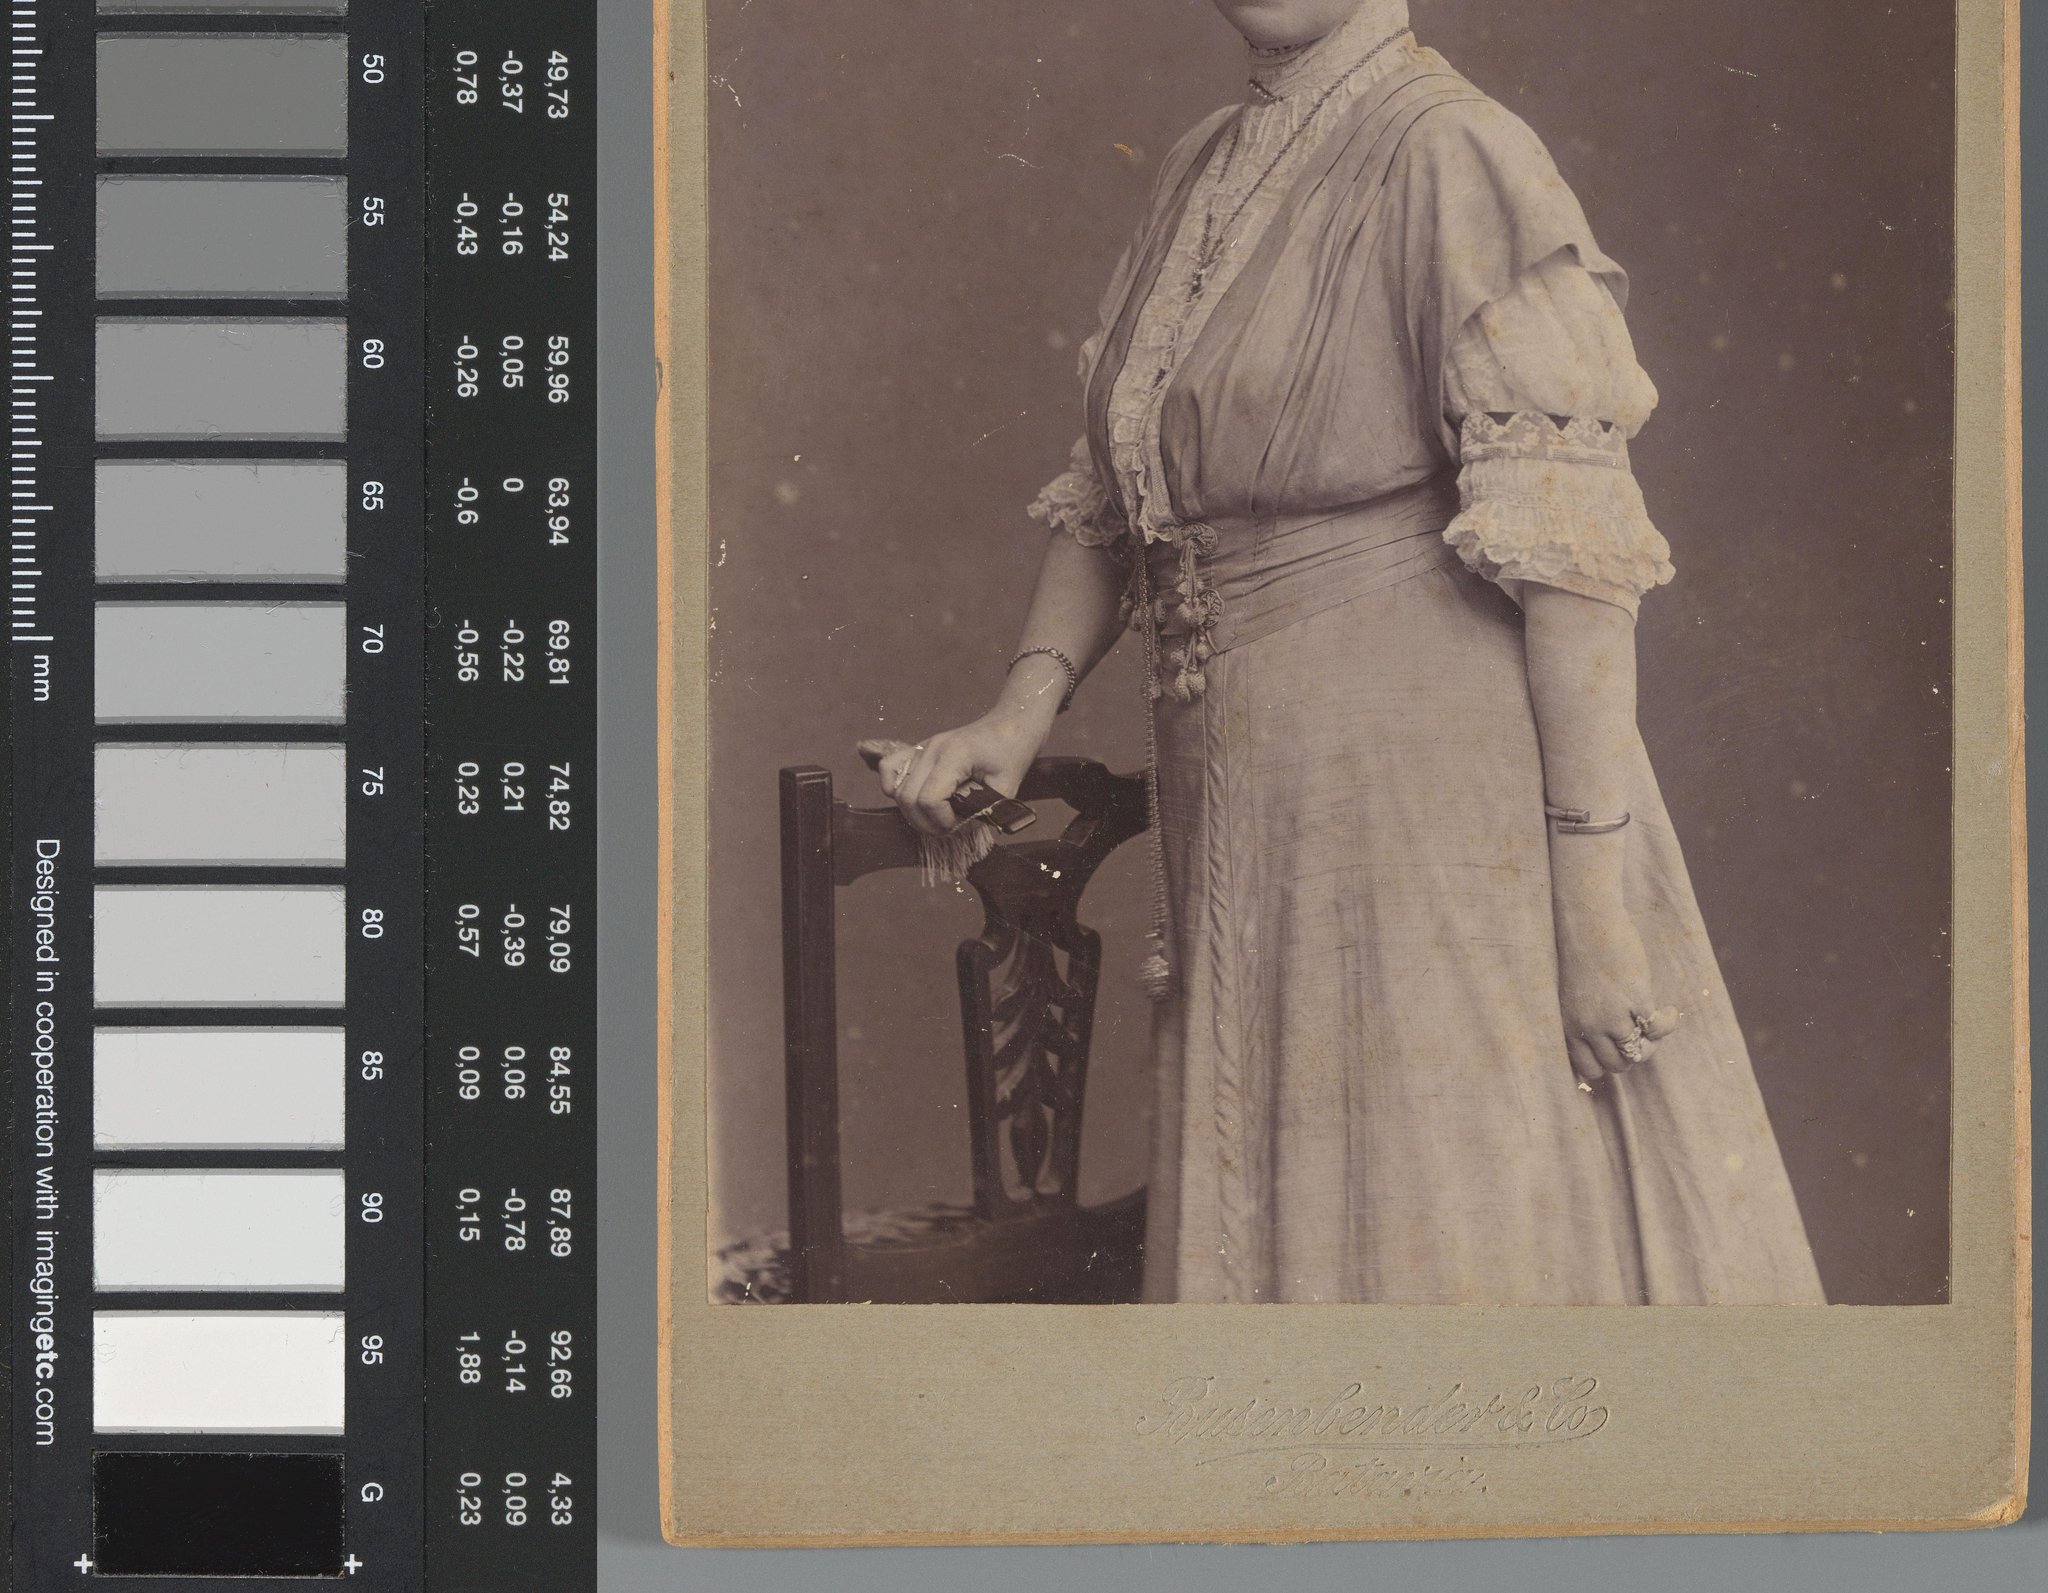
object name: cabinet photograph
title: Studioportret van Emilie van den Berg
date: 1890-1910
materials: cardboard, photographic support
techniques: albumen print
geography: batavia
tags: emilie albertine onnen-van den berg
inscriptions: name: ‘Busenbender & Co / Batavia.’, name: ‘Lietje Onnen - van den / Berg / (MB)’, name: ‘Photographie / Busenbender & Co / voorheen Woodbury & Page / BATAVIA’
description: Staand studioportret van Emilie van den Berg, met haar hand op de rugleuning van een stoel.